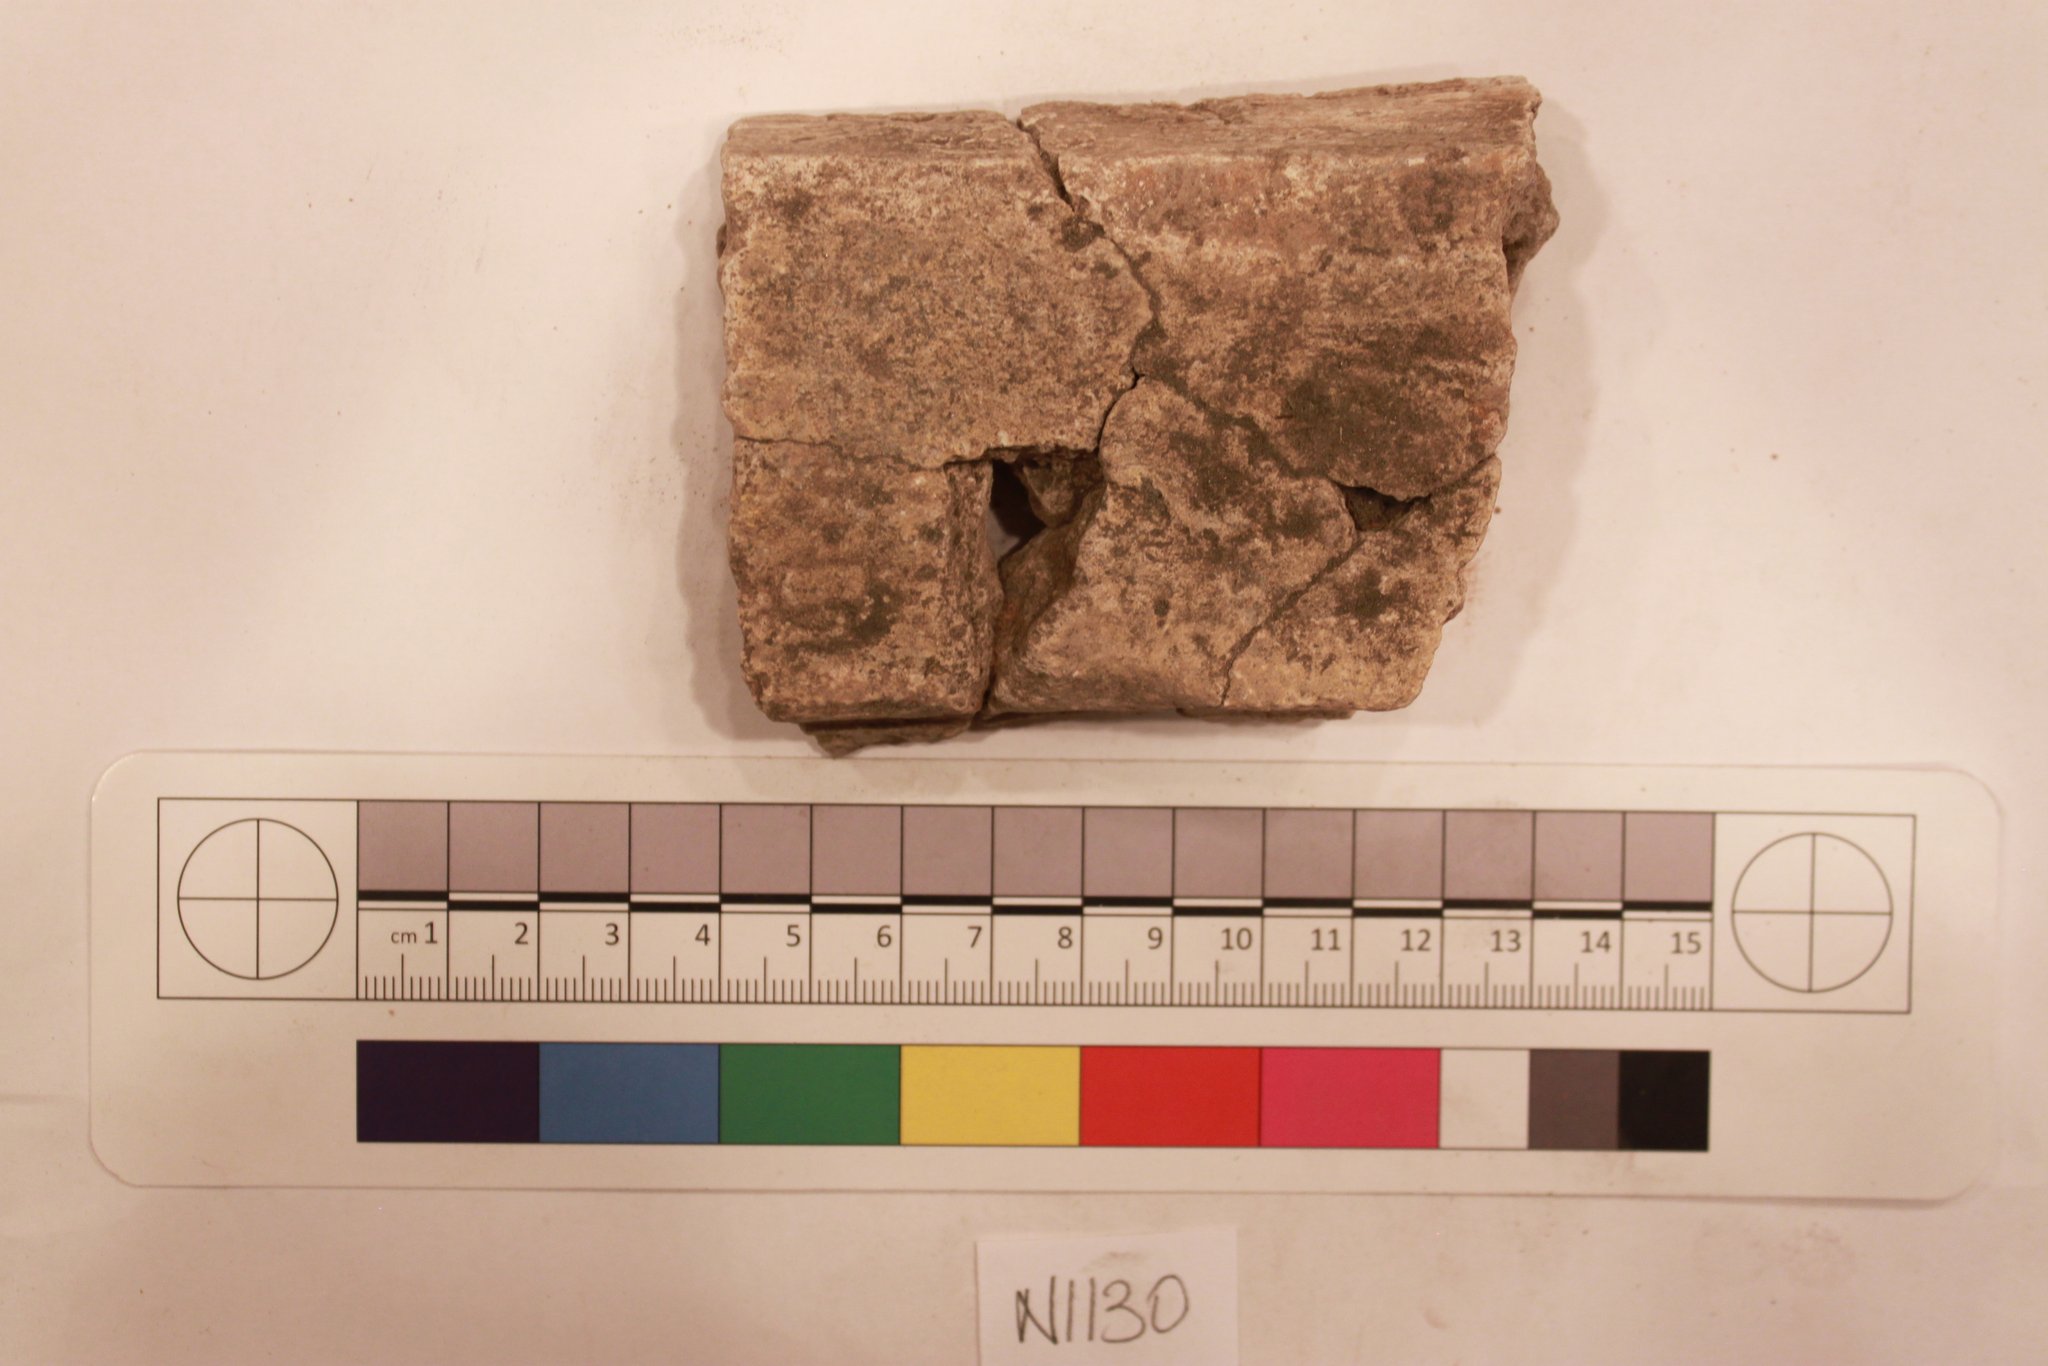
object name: fragment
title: Stucco Fragment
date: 701-1200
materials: plaster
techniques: carving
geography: iran